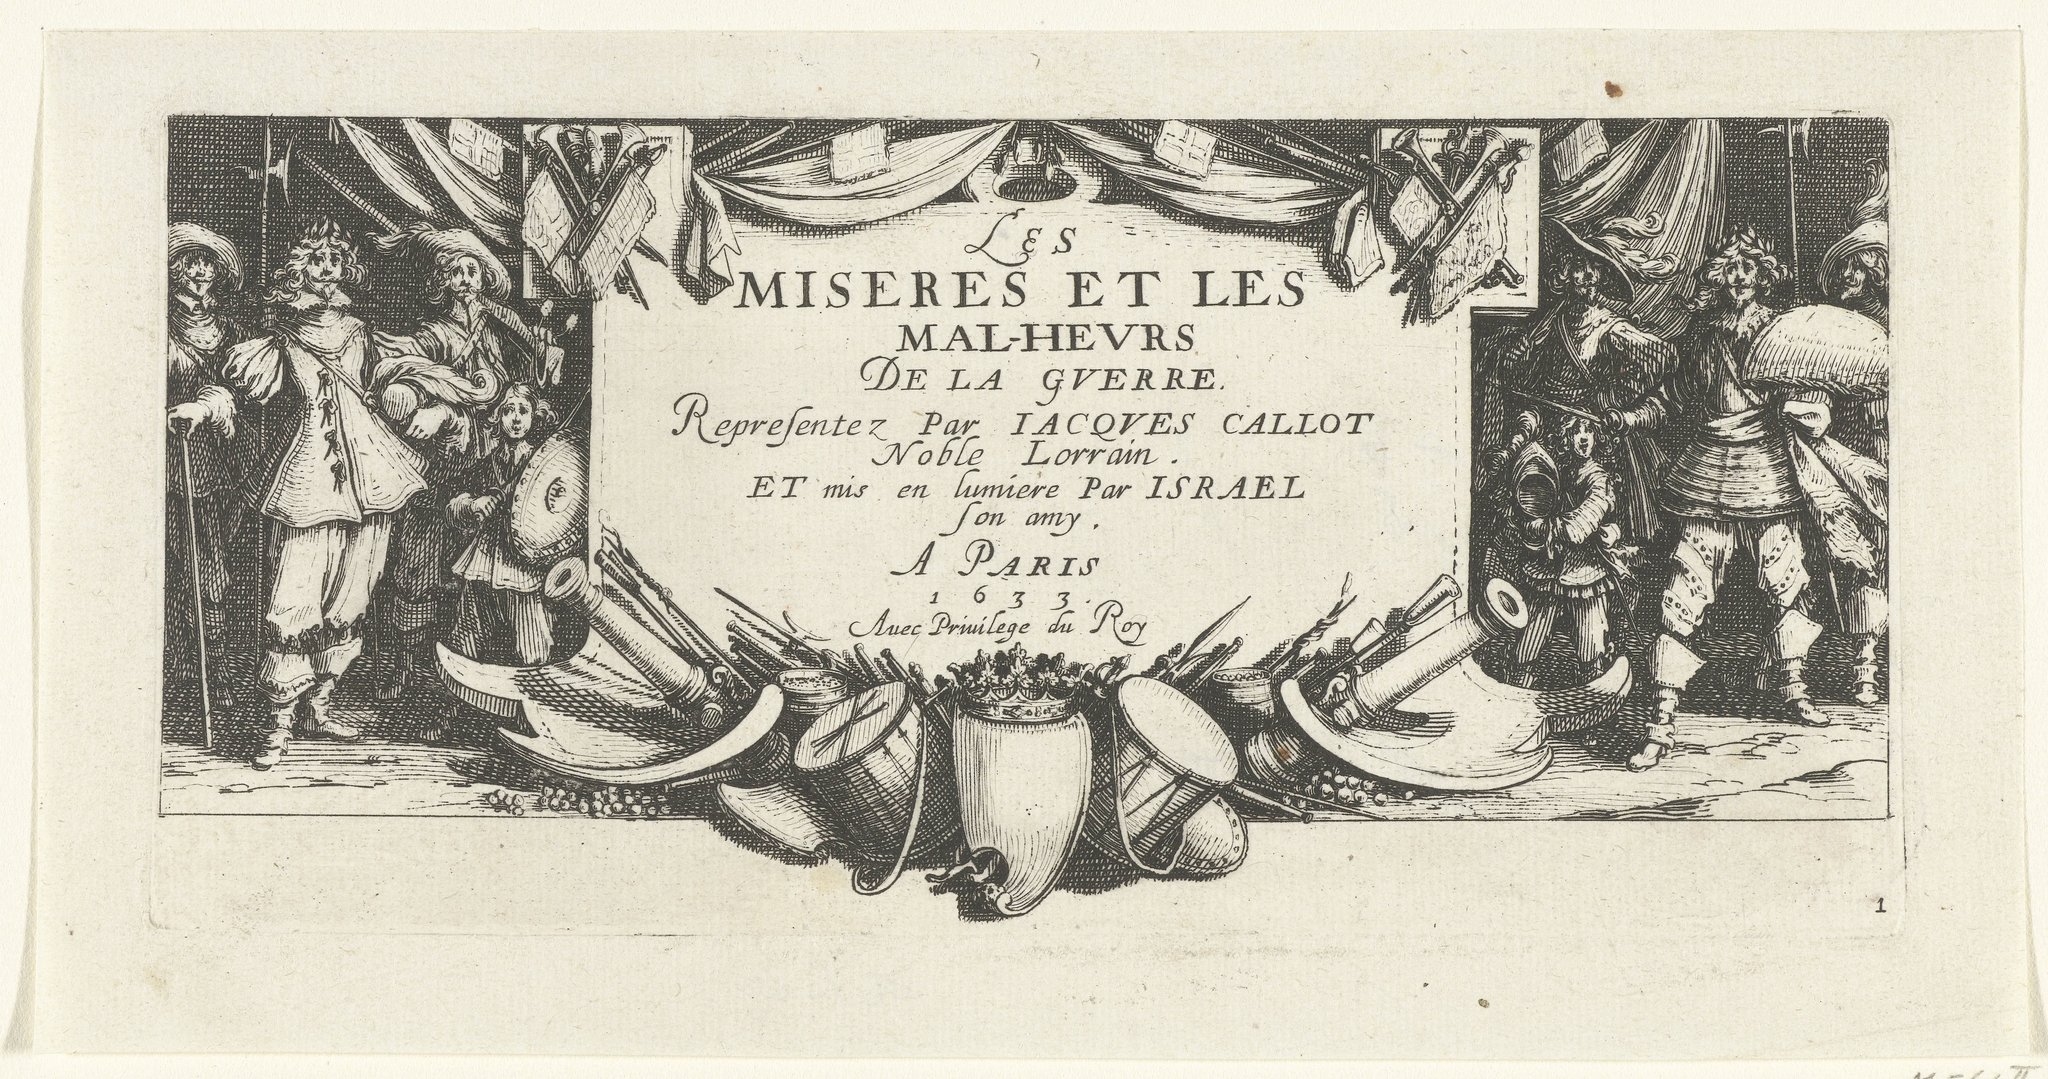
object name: print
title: Titelprent voor de prentserie 'De gruwelen van de oorlog (groot)' / 'Les miseres et les malheurs de la guerre'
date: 1633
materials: paper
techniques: etching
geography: paris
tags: crown (symbol of sovereignty), drum (musical instrument), weapons, firearms: cannon, officer, ornament ~ cartouche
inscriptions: collector's mark: Lugt 240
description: Franse tekst in cartouche in de vorm van een groot tablet. Op de voorgrond wapens, kogels, trommels en een kroon. Aan weerszijden van het tablet soldaten. Onder de voorstelling een lege marge. Dit is de titelprent voor een serie van 17 prenten met voorstellingen van diverse soorten ellende die oorlogvoering met zich meebrengt.